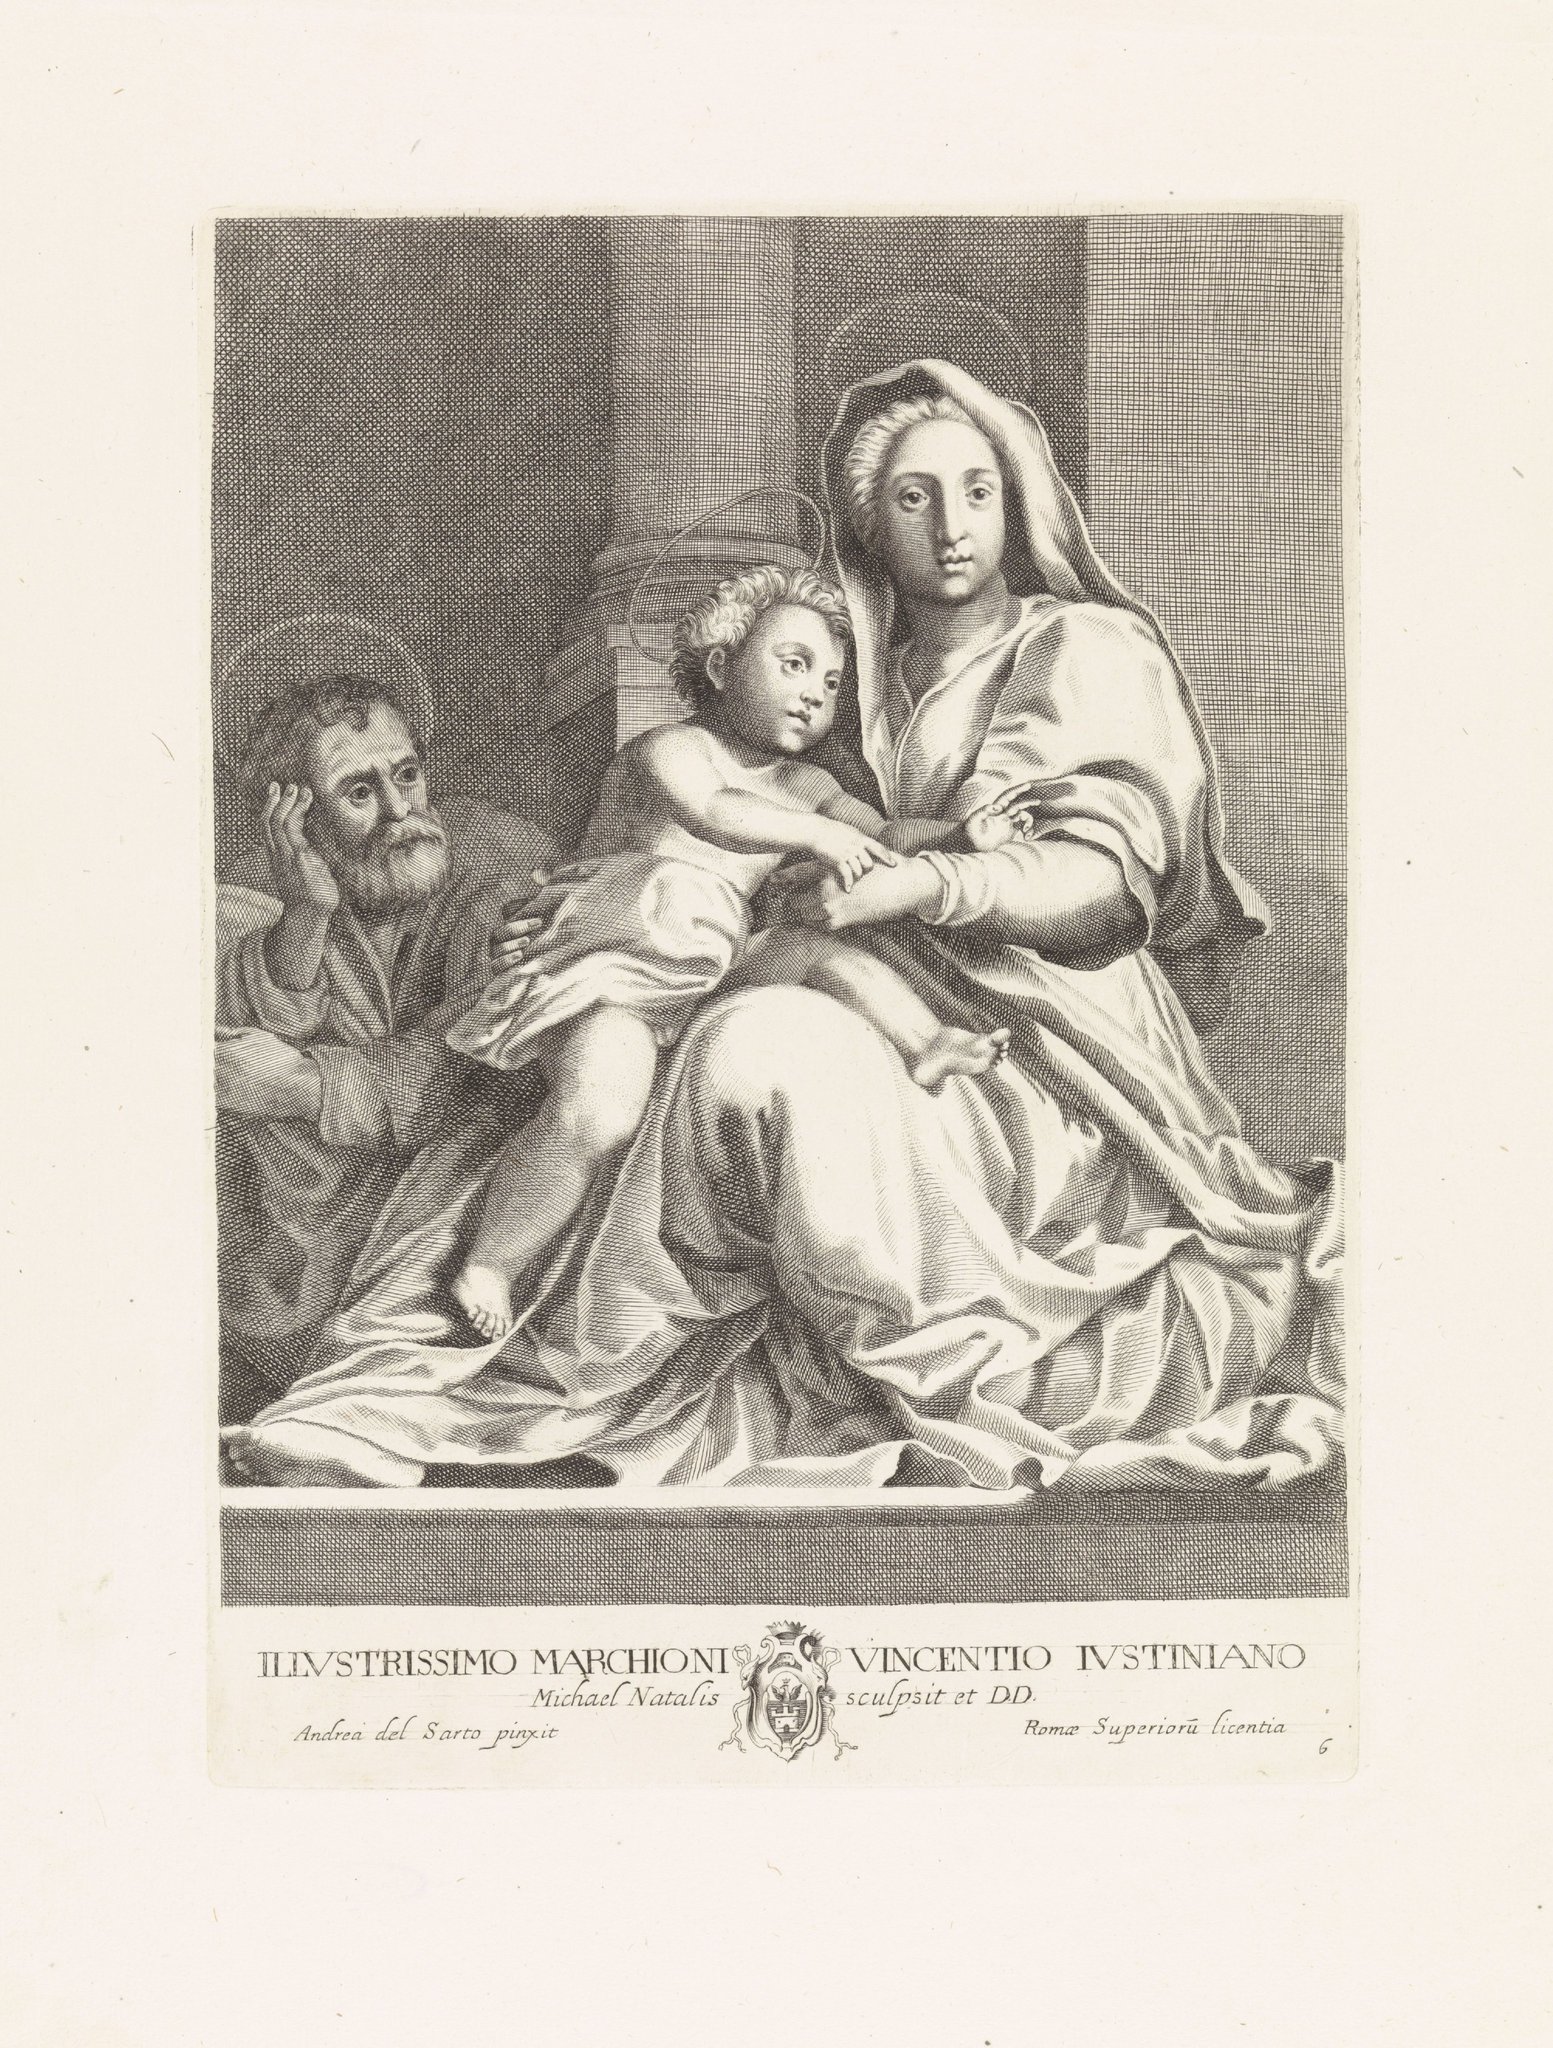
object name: print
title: Heilige Familie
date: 1632-1633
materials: paper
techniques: engraving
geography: rome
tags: holy family, and derived representations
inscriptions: collector's mark: Lugt 2228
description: Maria met het Christuskind op haar schoot, Jozef zit naast hen. Midden onder in de marge het wapenschild van Vincenzo Giustiniani. Linksonder genummerd: 6.